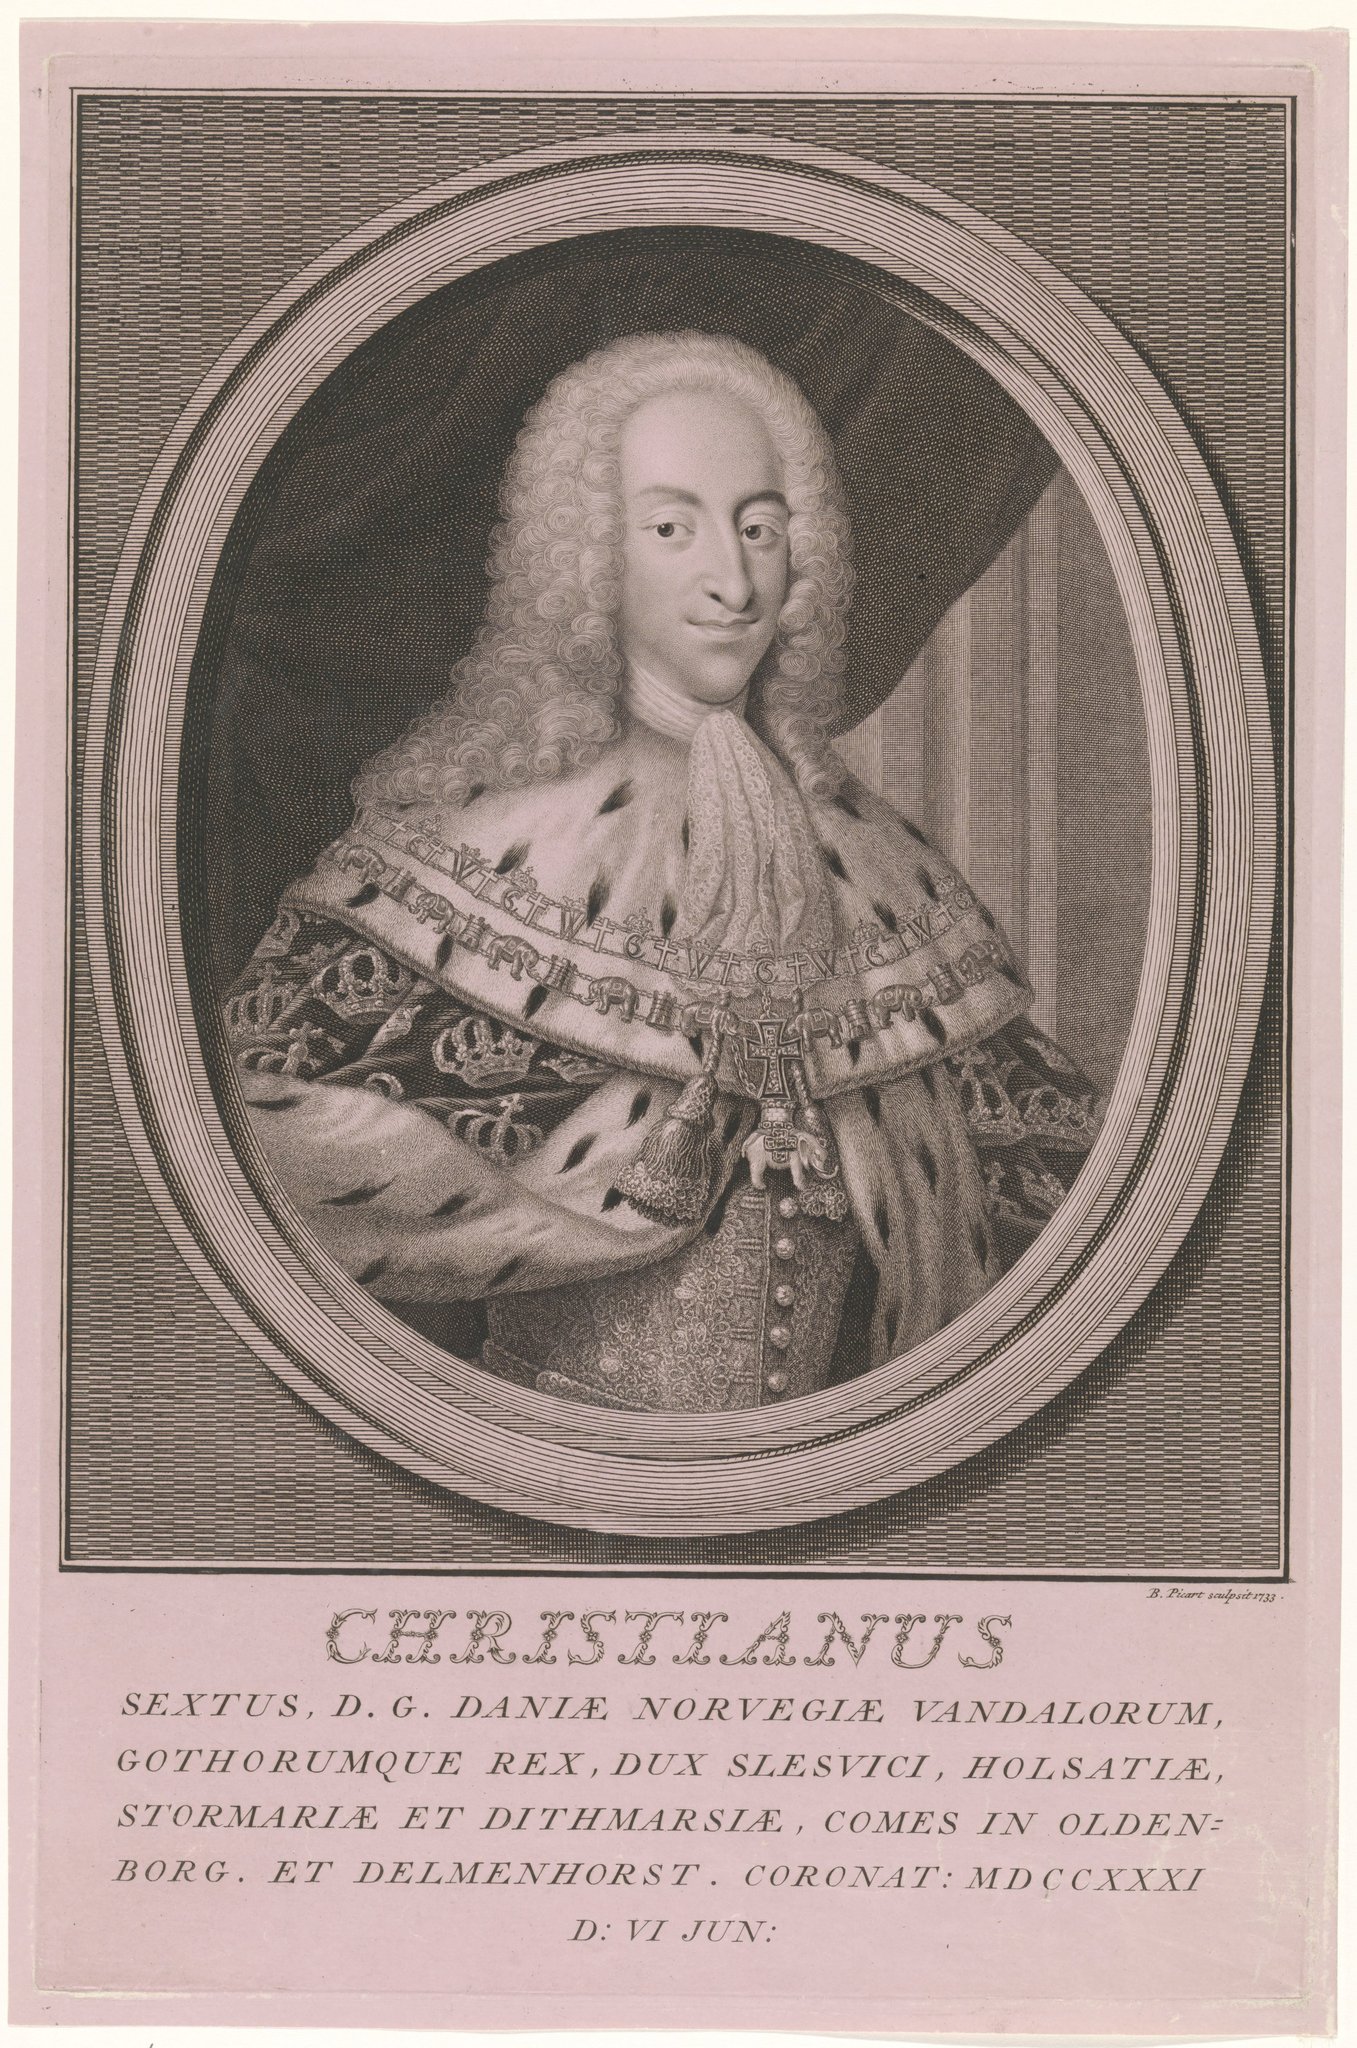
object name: print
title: Portret van Christiaan VI van Denemarken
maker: bernard picart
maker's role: draughtsman, print maker, publisher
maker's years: 1673-1733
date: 1733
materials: paper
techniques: engraving, etching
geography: amsterdam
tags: copenhagen (city), knighthood order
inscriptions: collector's mark: Lugt 2228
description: Portret van Christiaan VI, koning van Denemarken en Noorwegen. Hij draagt een keten met de Orde van de Olifant. In de marge een vijfregelig onderschrift in het Latijn.